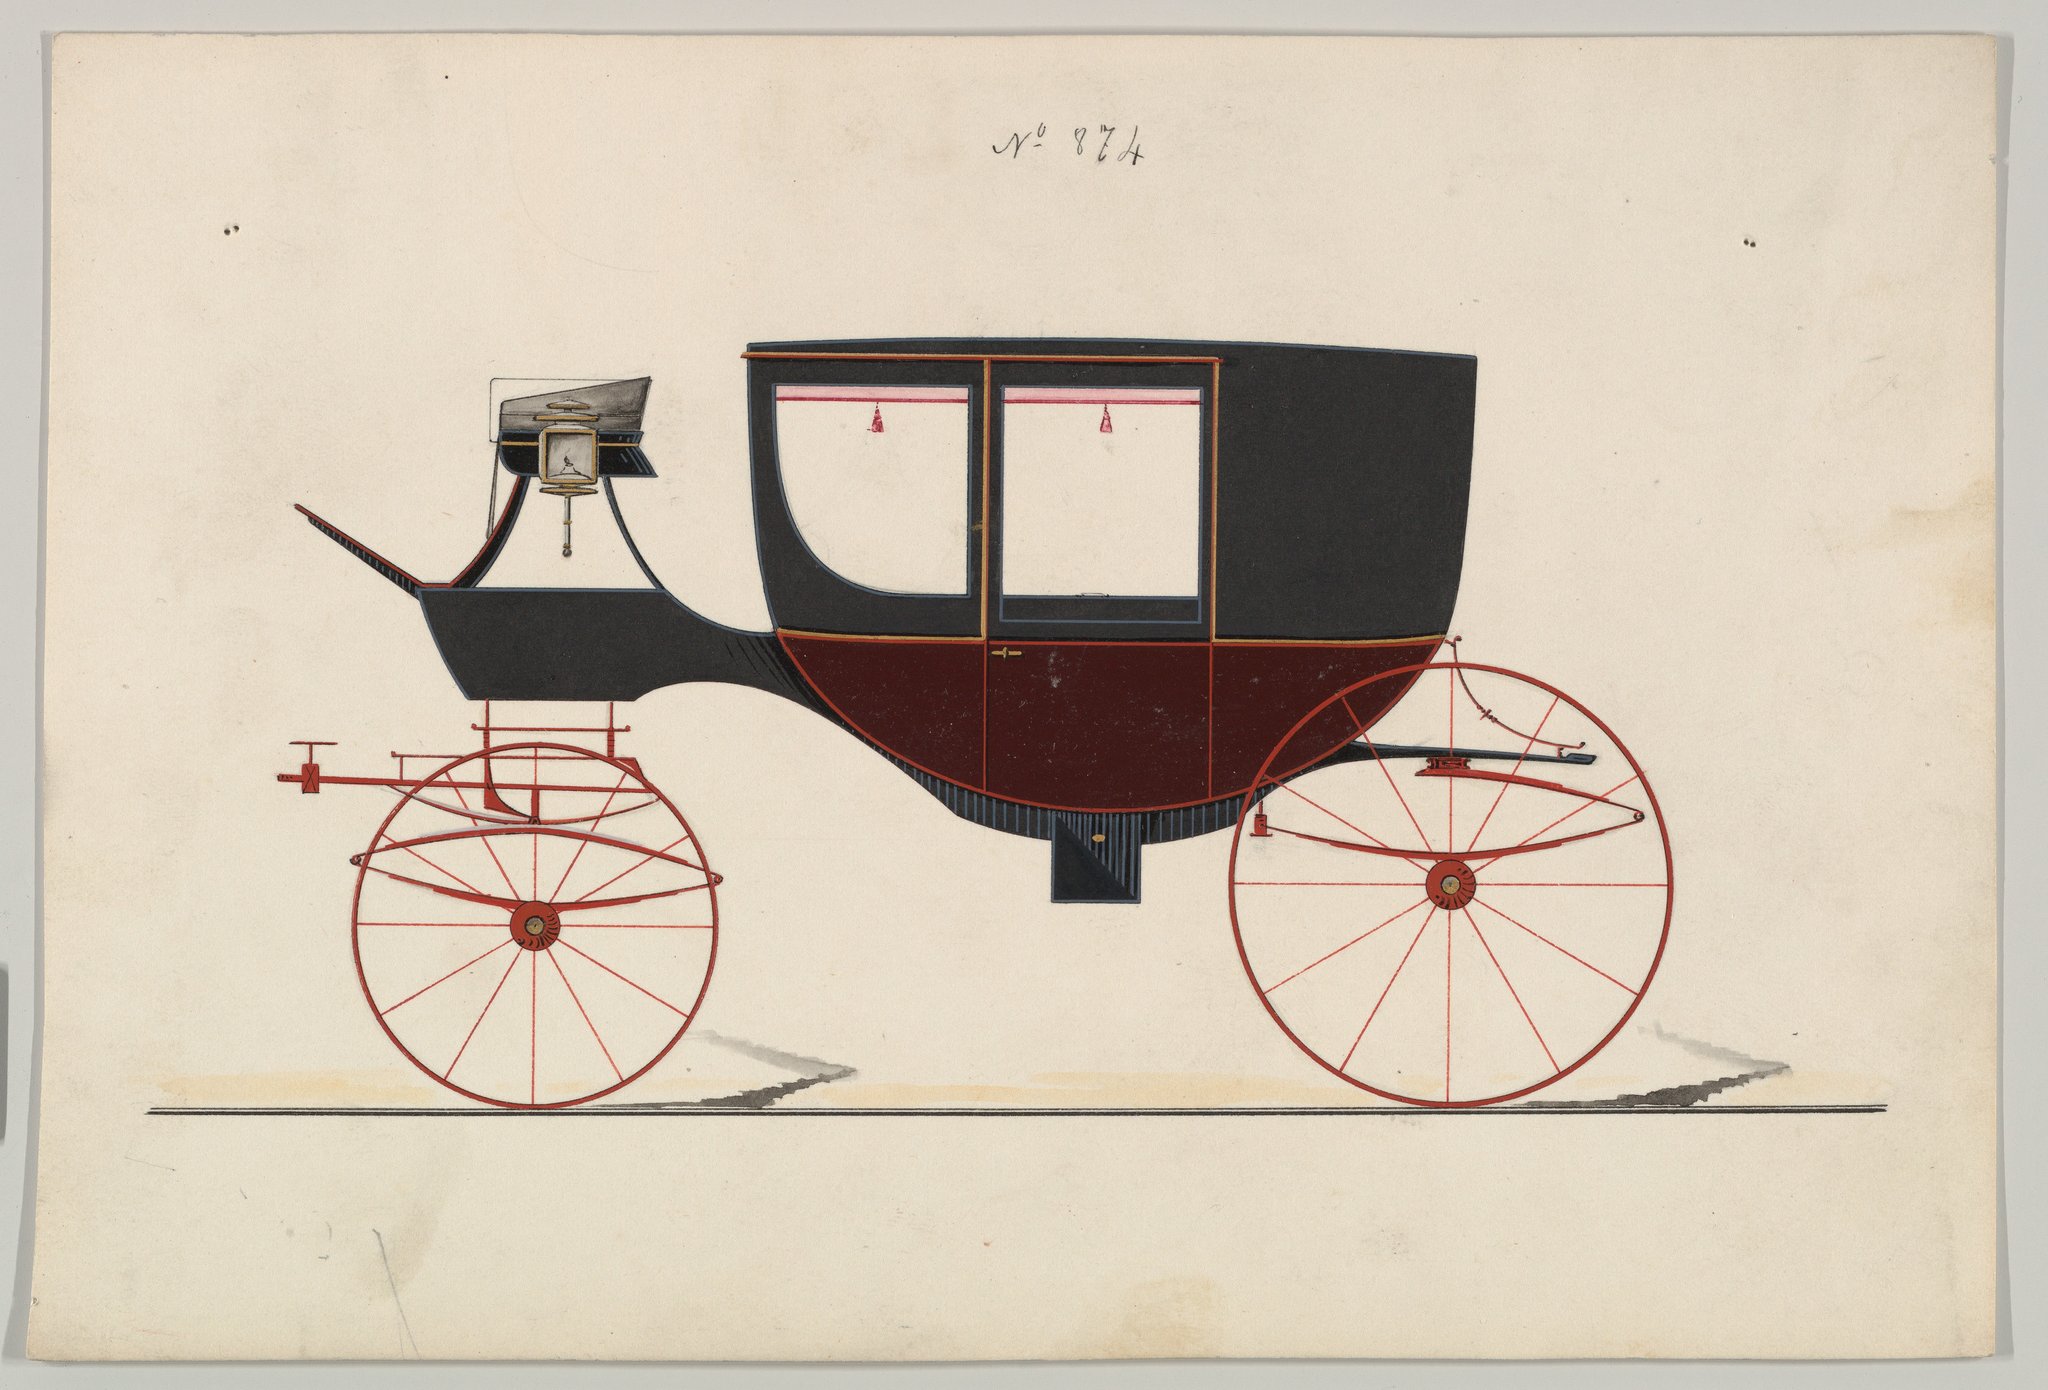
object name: drawing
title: Coach # 874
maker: brewster & co.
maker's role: manufacturer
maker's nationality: american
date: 1870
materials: gouache, gum arabic, ink, watercolor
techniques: pen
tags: carriages